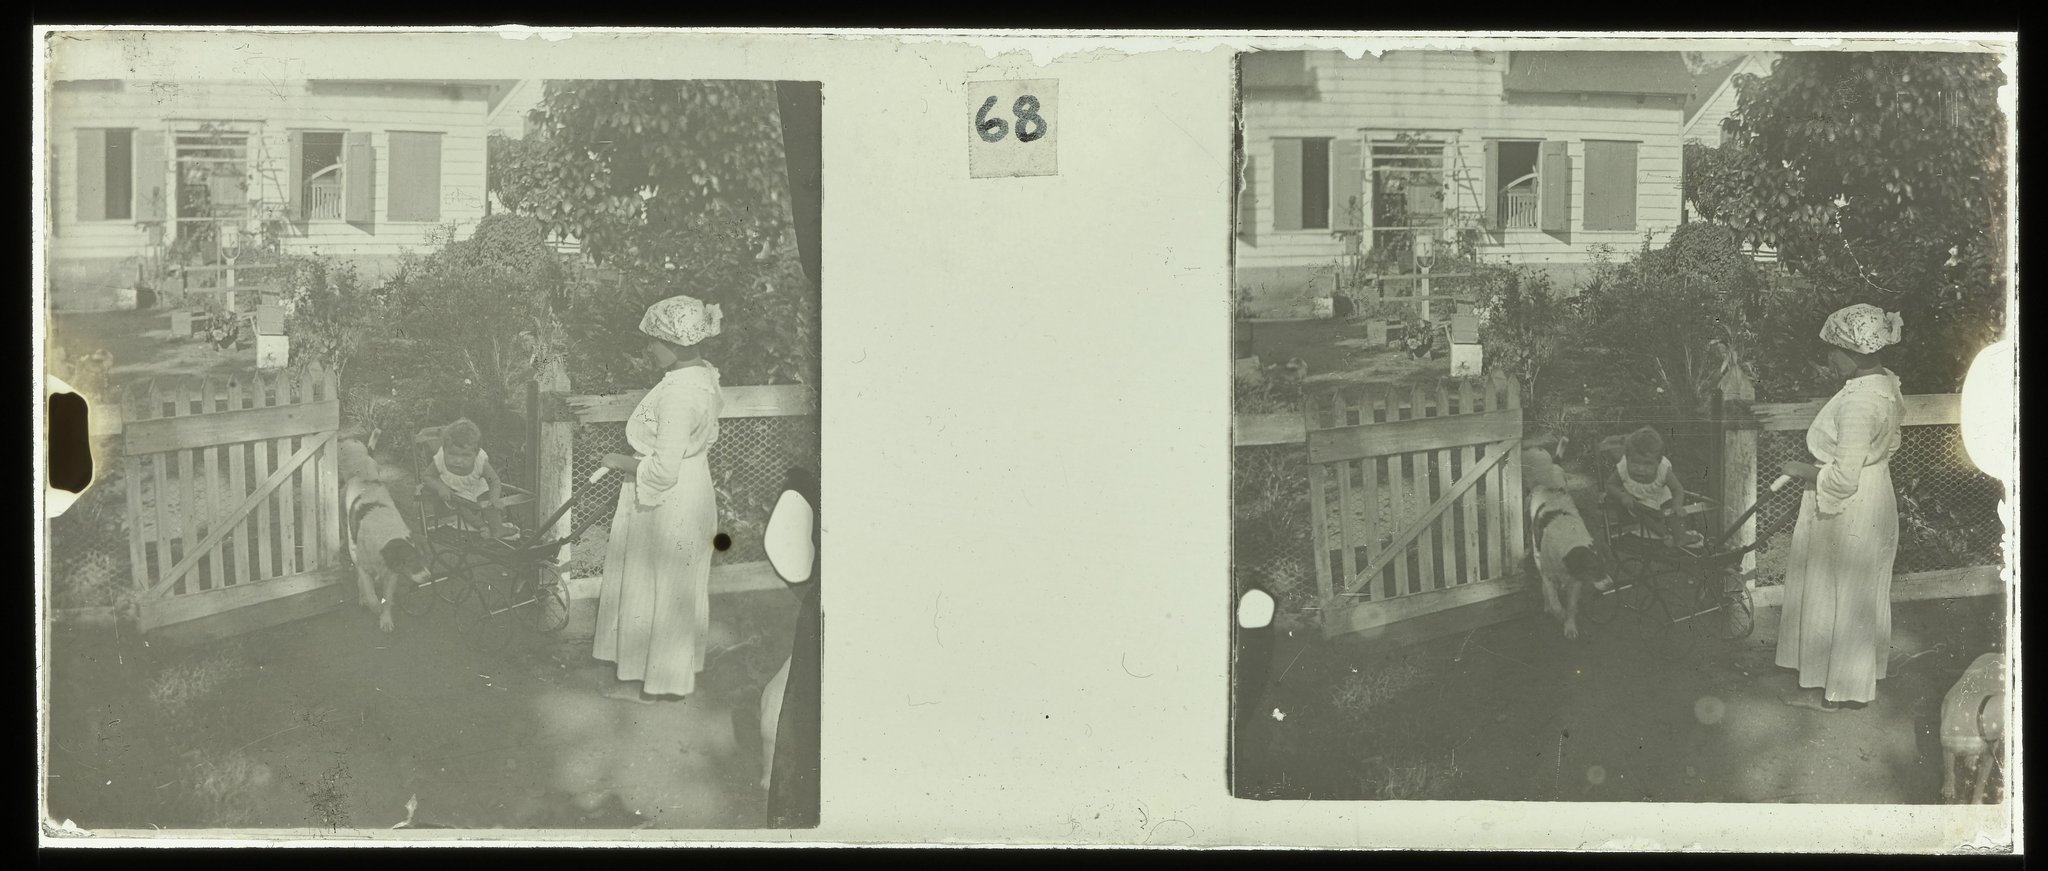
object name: stereograph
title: Nene Mathilde op Plantage Accaribo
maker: theodoor brouwers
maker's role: amateurfotograaf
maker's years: 1874-1932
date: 1913-1930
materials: glass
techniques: photography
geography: suriname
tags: amsterdam, theodoor brouwers, plantation, suriname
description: In de periode 1911-1932 woonde op plantage Accaribo in Suriname de familie Brouwers van wie de foto's afkomstig zijn. Rond 1910 vond Theodoor Brouwers werk op plantage Accaribo. In 1929 werd hij eigenaar van de plantage. Op Accaribo werden in zijn tijd bananen geproduceerd en wat koffie.